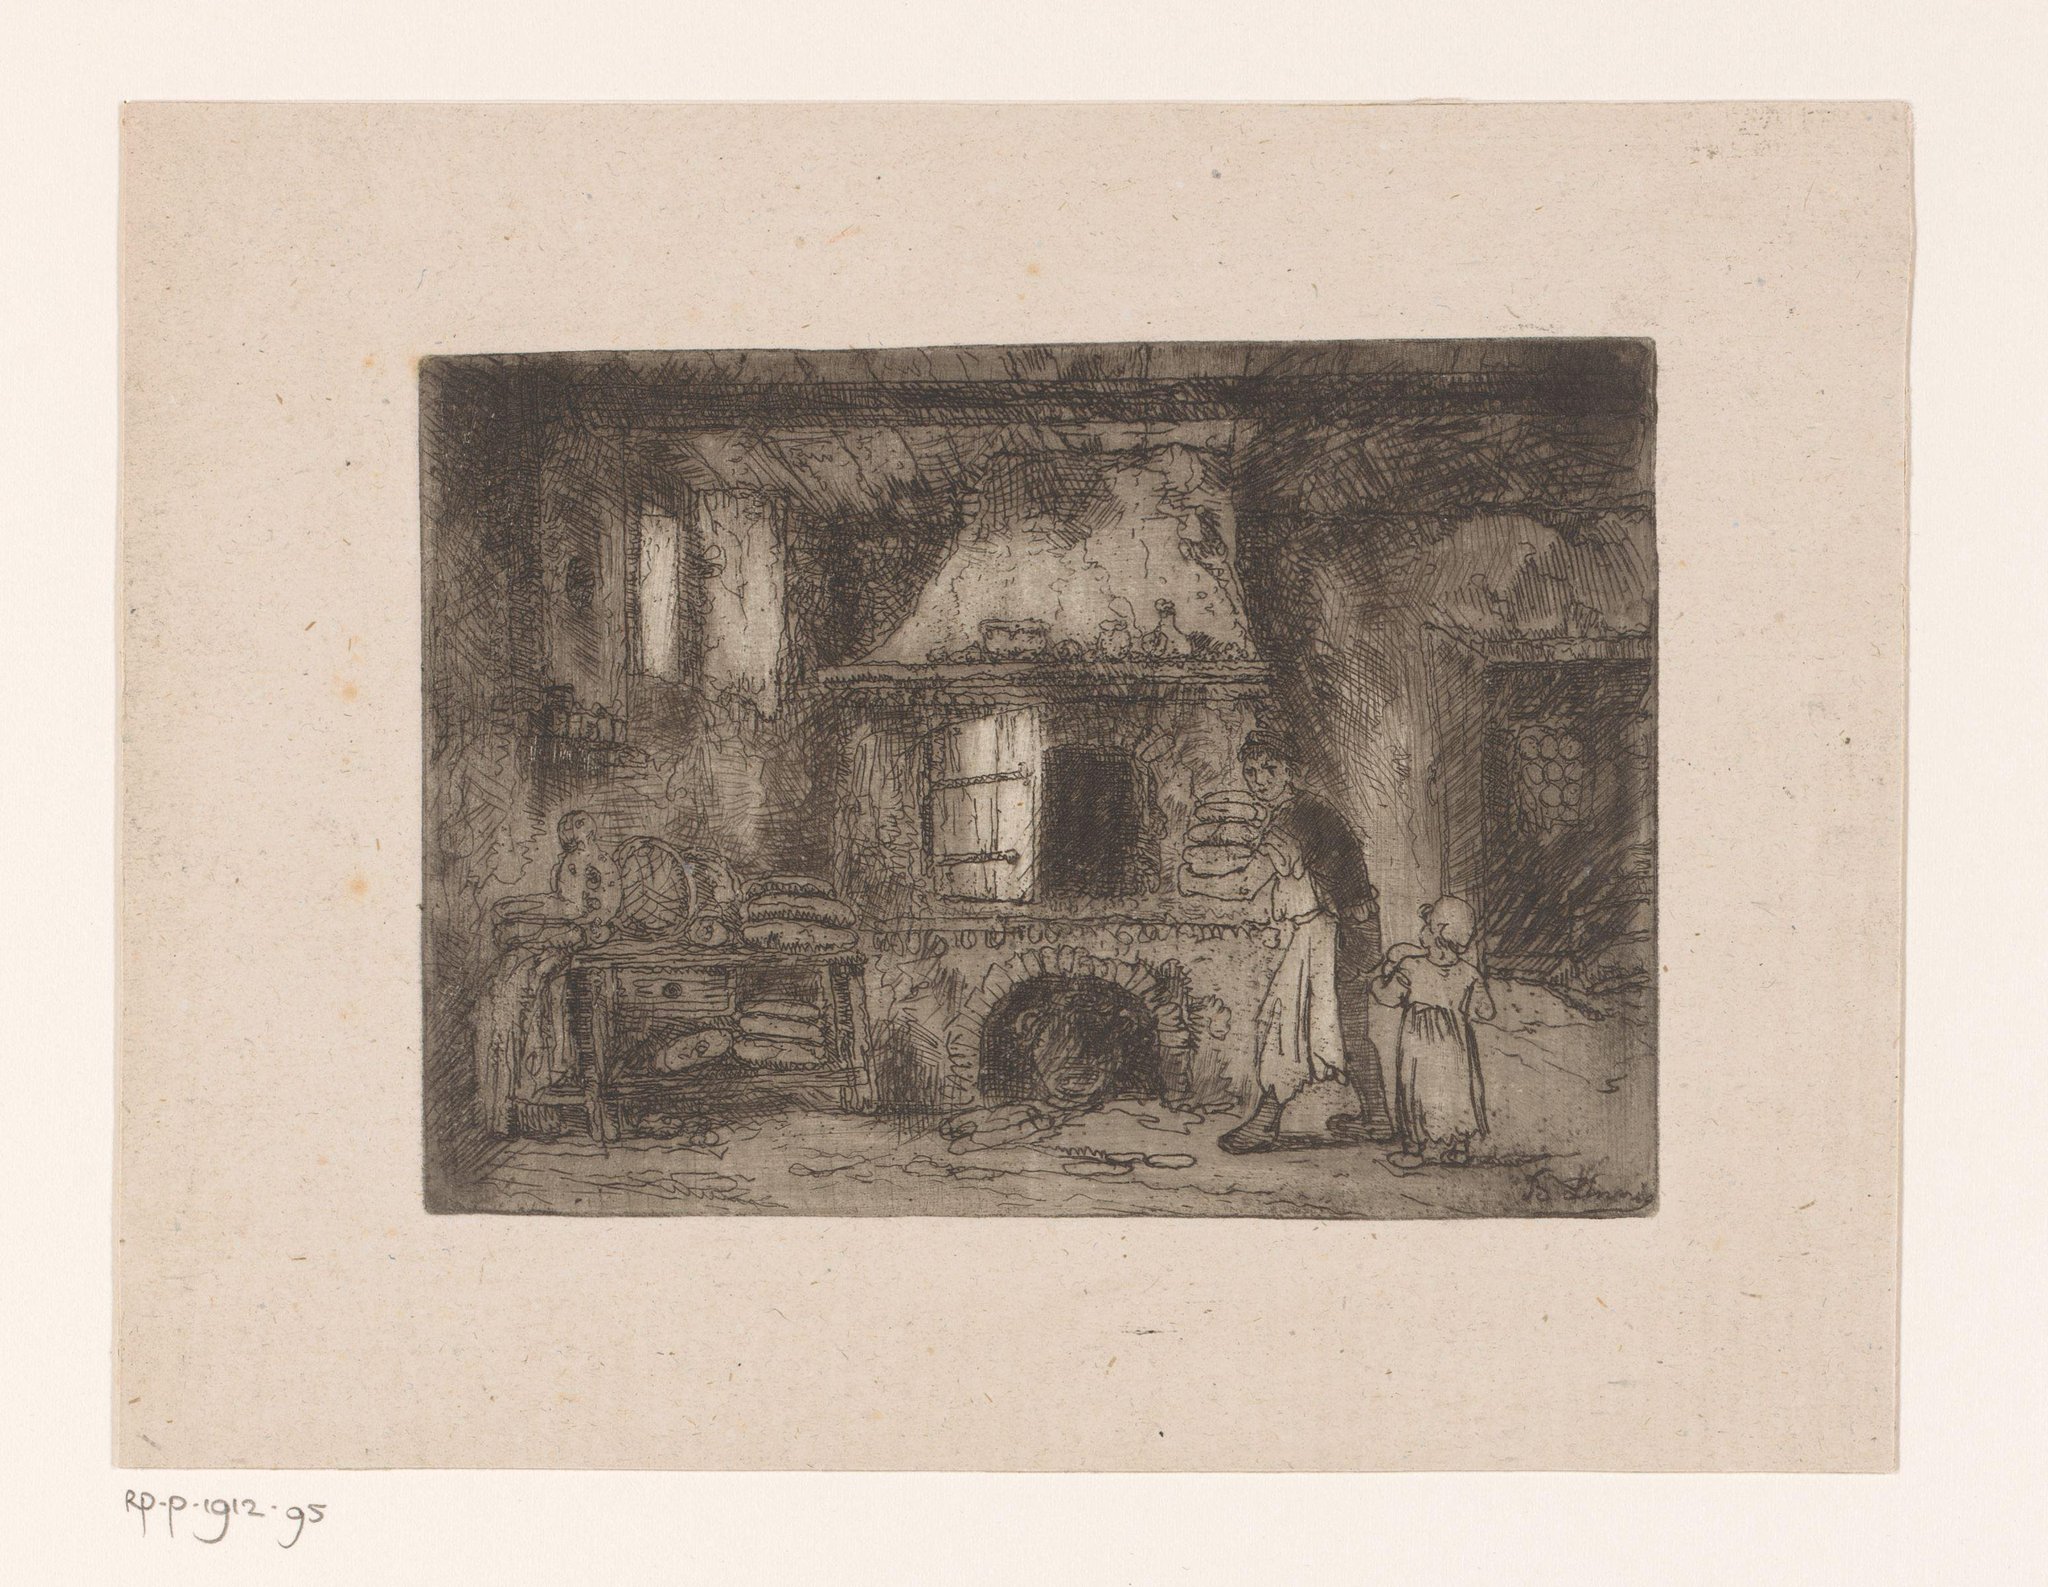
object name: print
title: Interieur van een bakkerij met bakker en kind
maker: ben linnig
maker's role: print maker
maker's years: 1860-1929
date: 1870-1912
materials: paper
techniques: drypoint, etching, intaglio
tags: oven ~ kitchen, bread, loaf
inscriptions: collector's mark: Lugt 2228